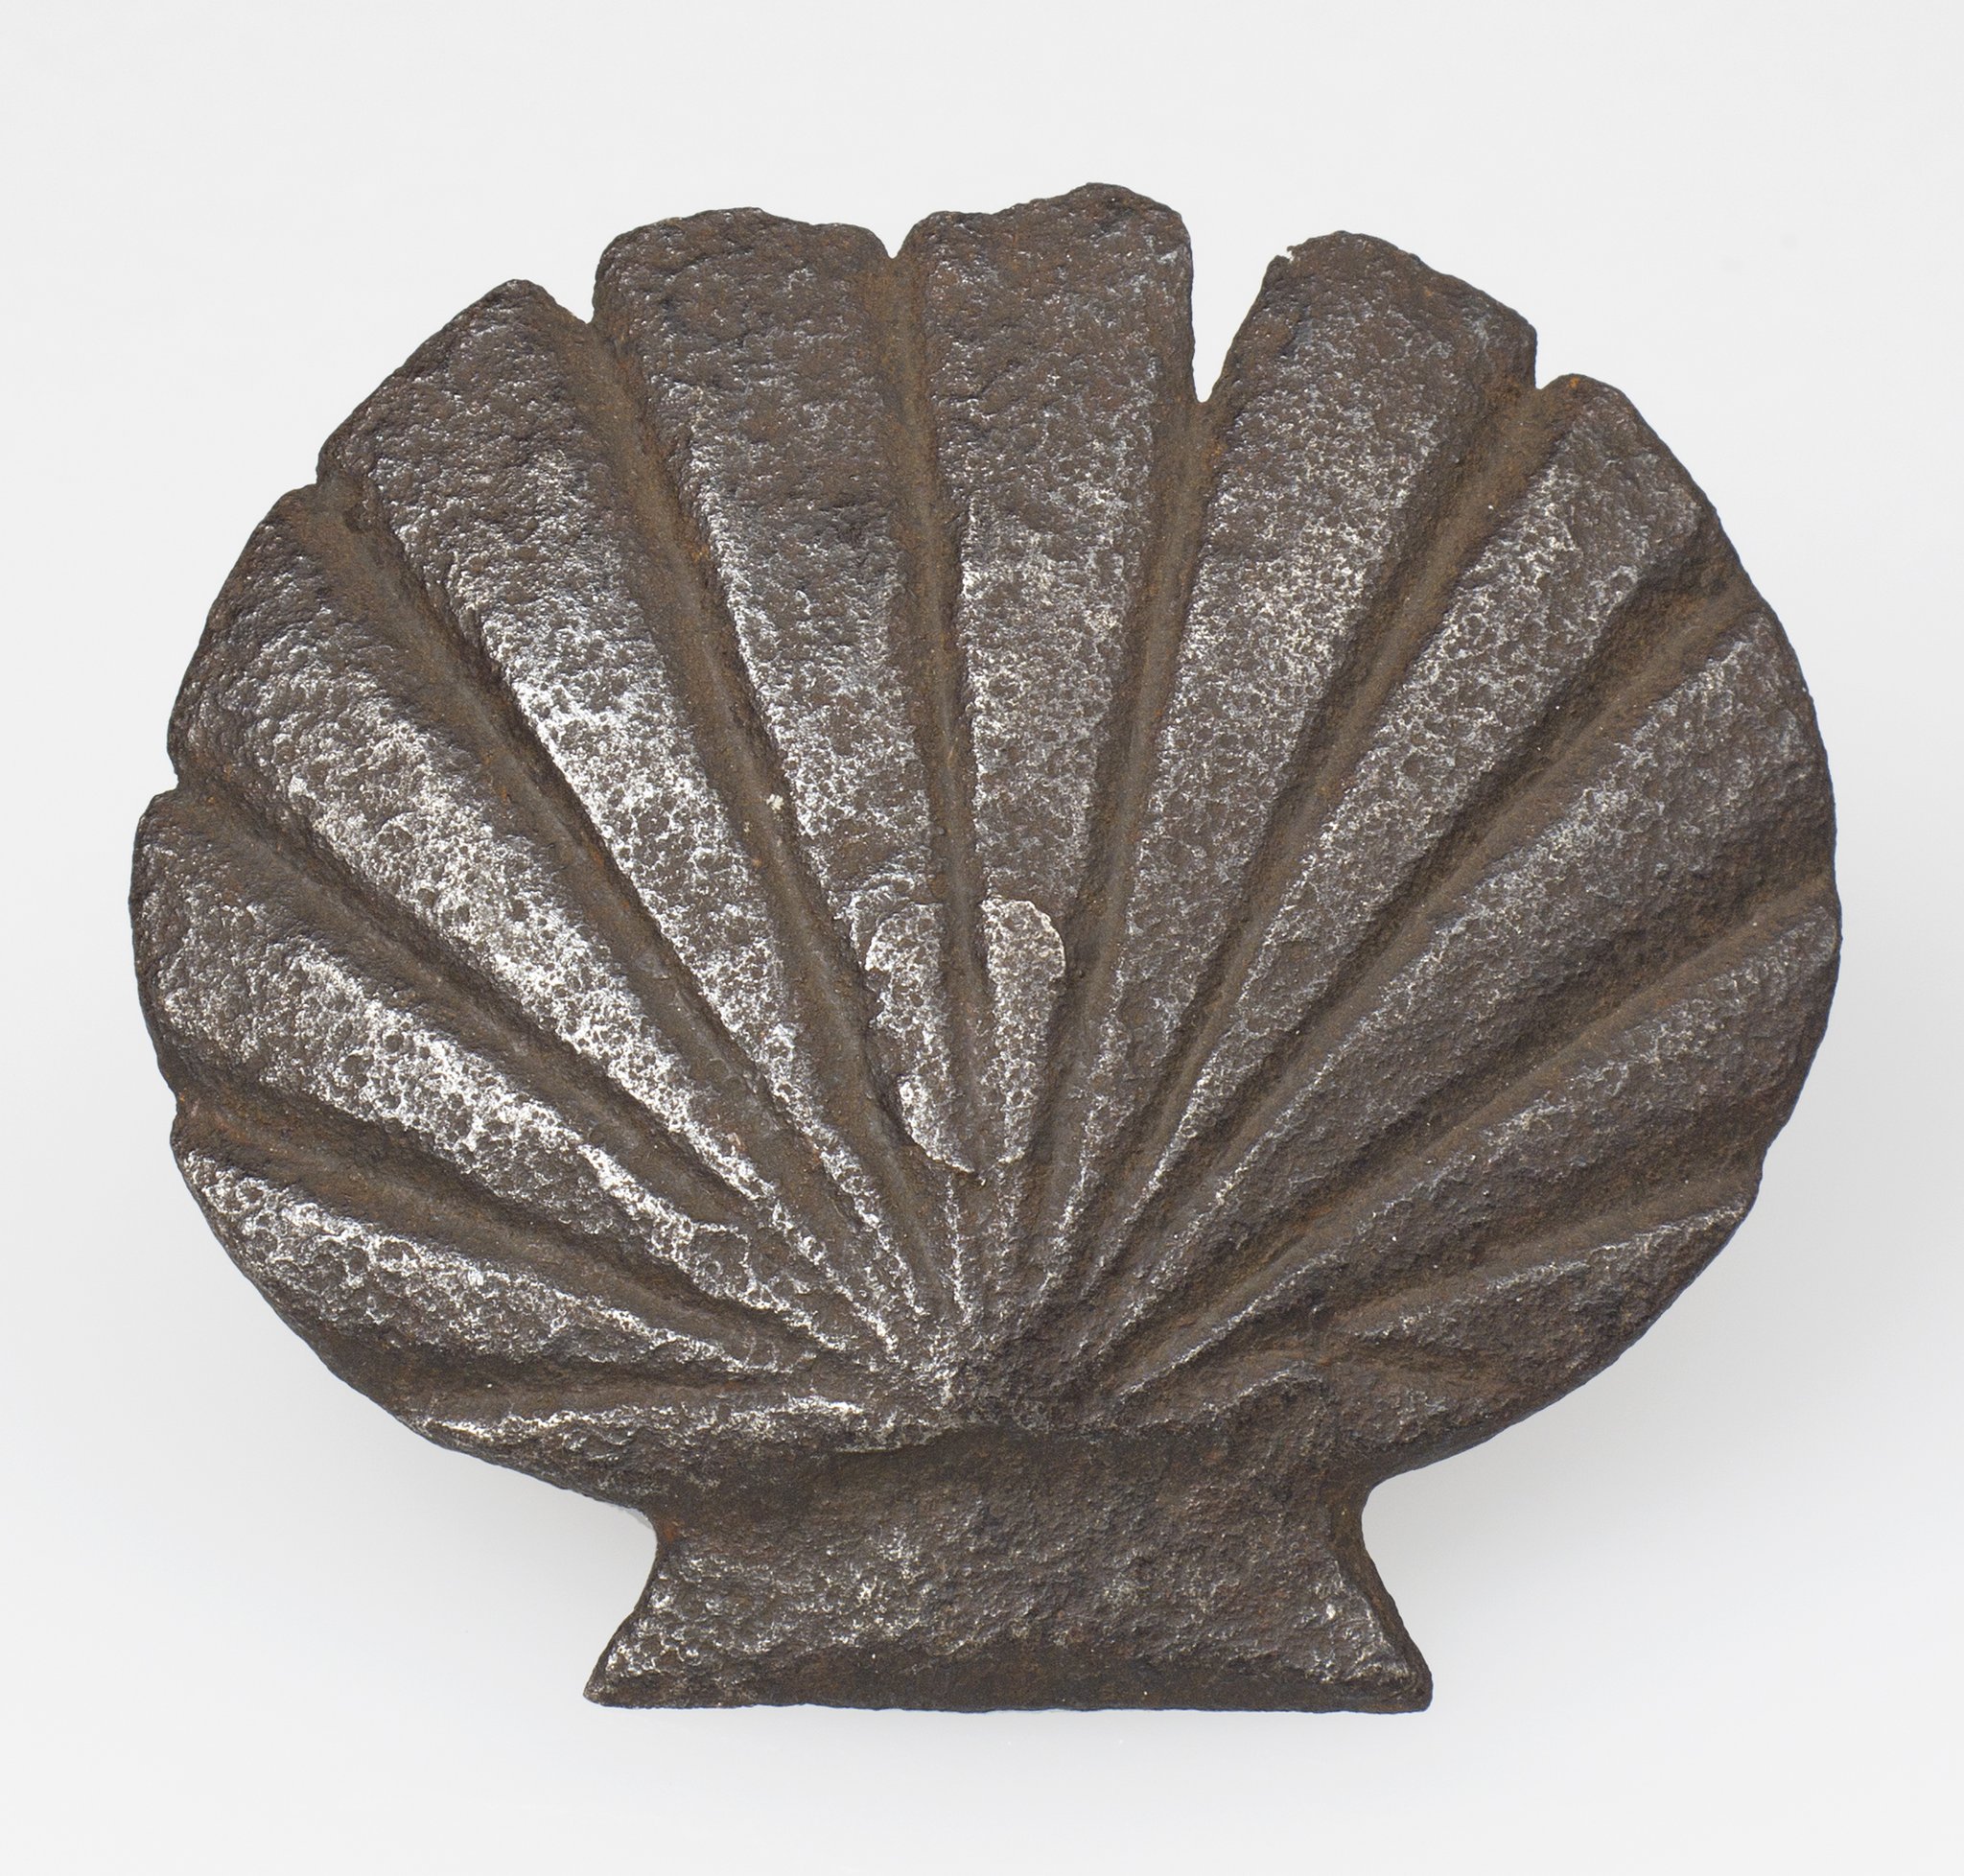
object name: nail head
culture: european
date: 1401-1600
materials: iron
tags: shells